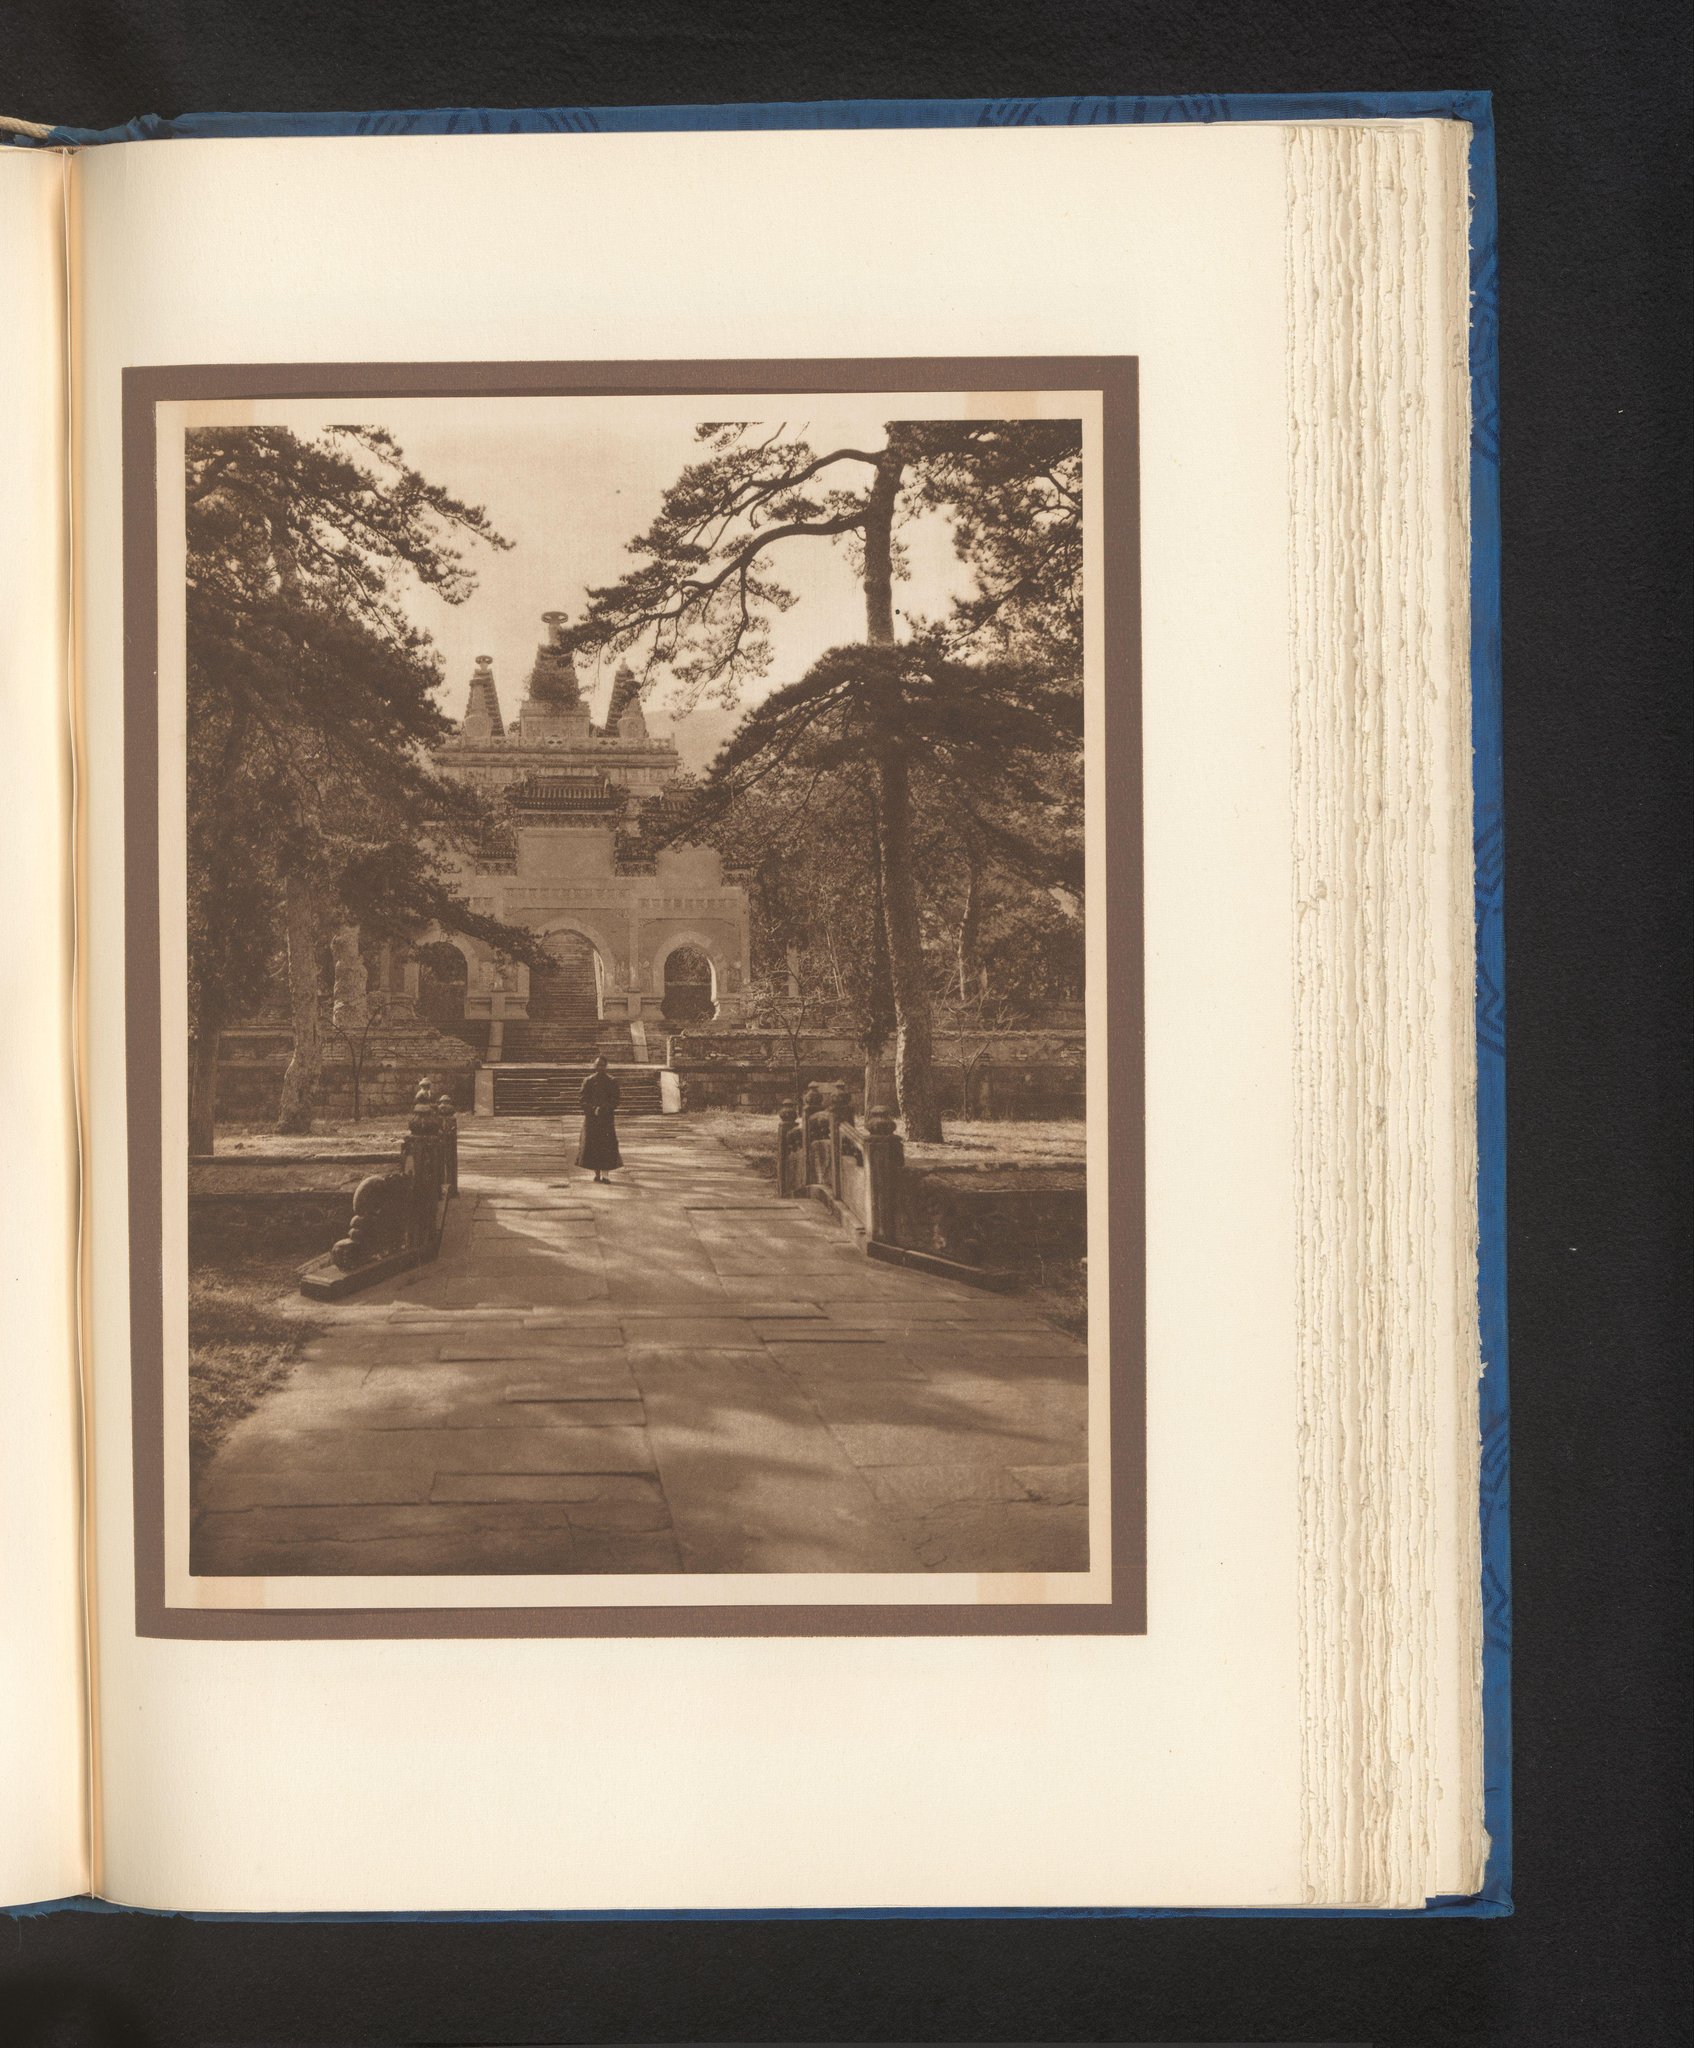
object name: page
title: Onbekende man bij een tempel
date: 1915-1920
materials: paper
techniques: rotogravure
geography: beijing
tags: adult man, historical persons, temple, shrine ~ non-christian religions